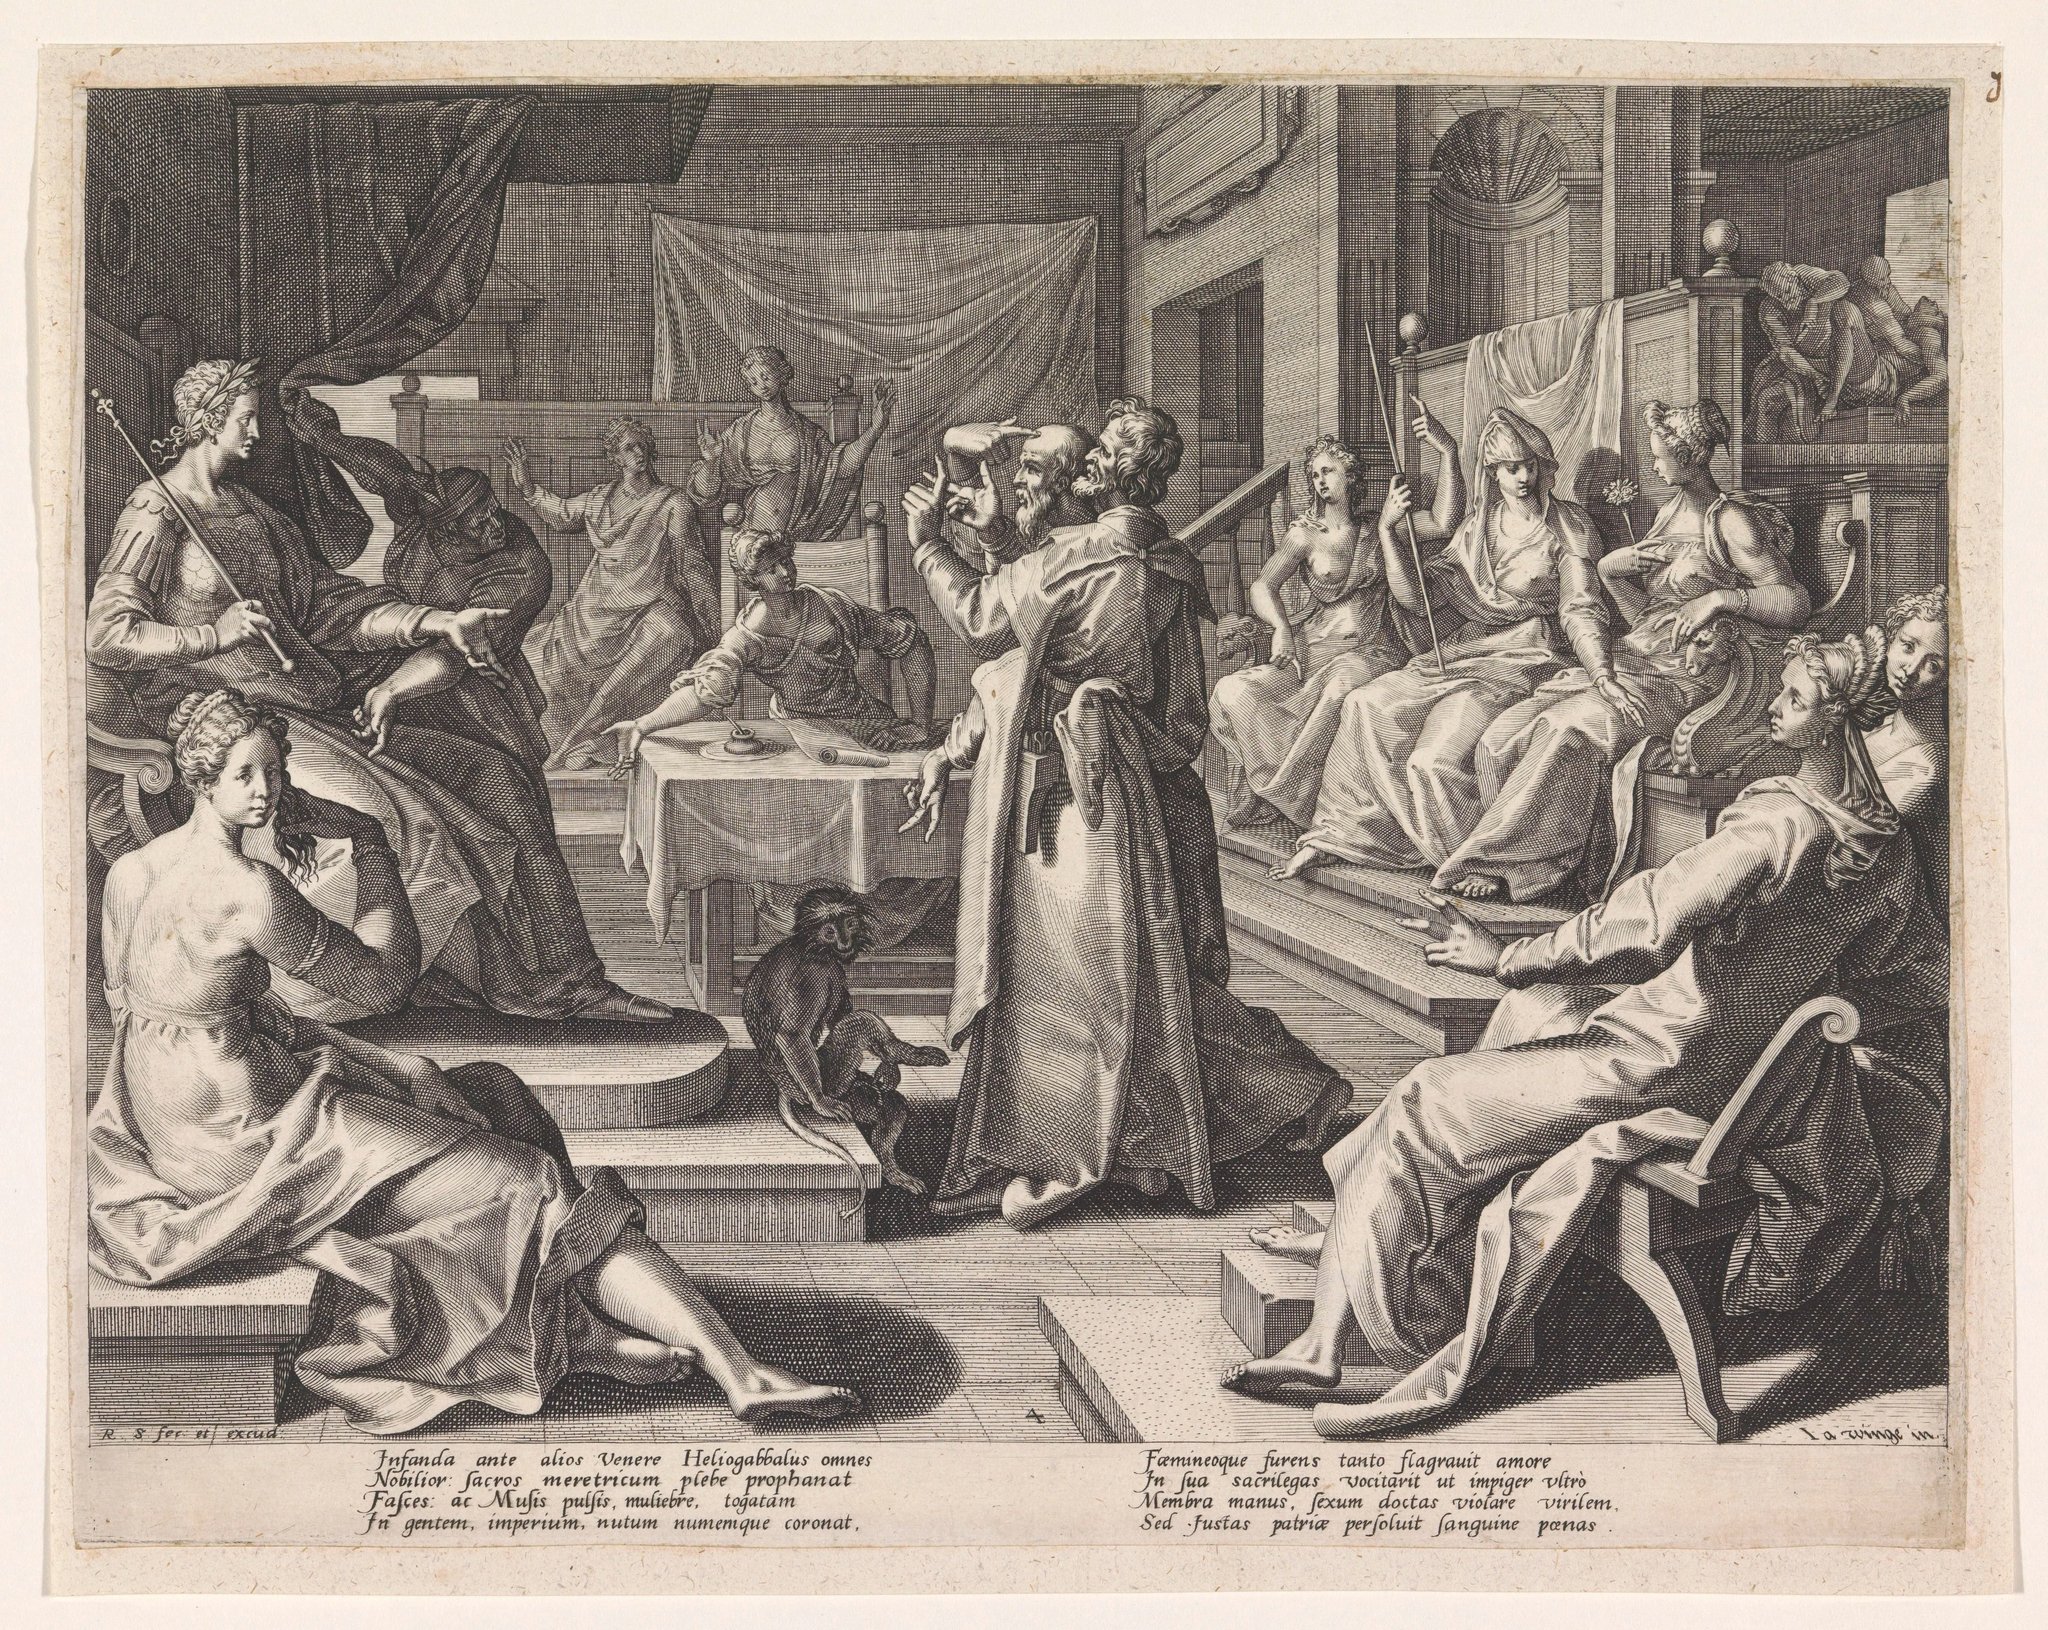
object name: print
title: Over de macht van vrouwen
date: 1589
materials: paper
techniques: engraving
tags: male persons from classical history (elagabalus), pernicious influence of women, 'femmes fatales', castration, discussion, dialogue, dispute ~ scholar, philosopher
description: Keizer Heliogabal te midden van zijn vrouwelijke hofhouding. Hij is uitgebeeld als een jonge vorst en is in gesprek met twee geleerde filosofen die hem op andere gedachten lijken te willen brengen. Voor de troon zit een aapje. Op de achtergrond rechts het lot van keizer Heliogabal: hij wordt gecastreerd.